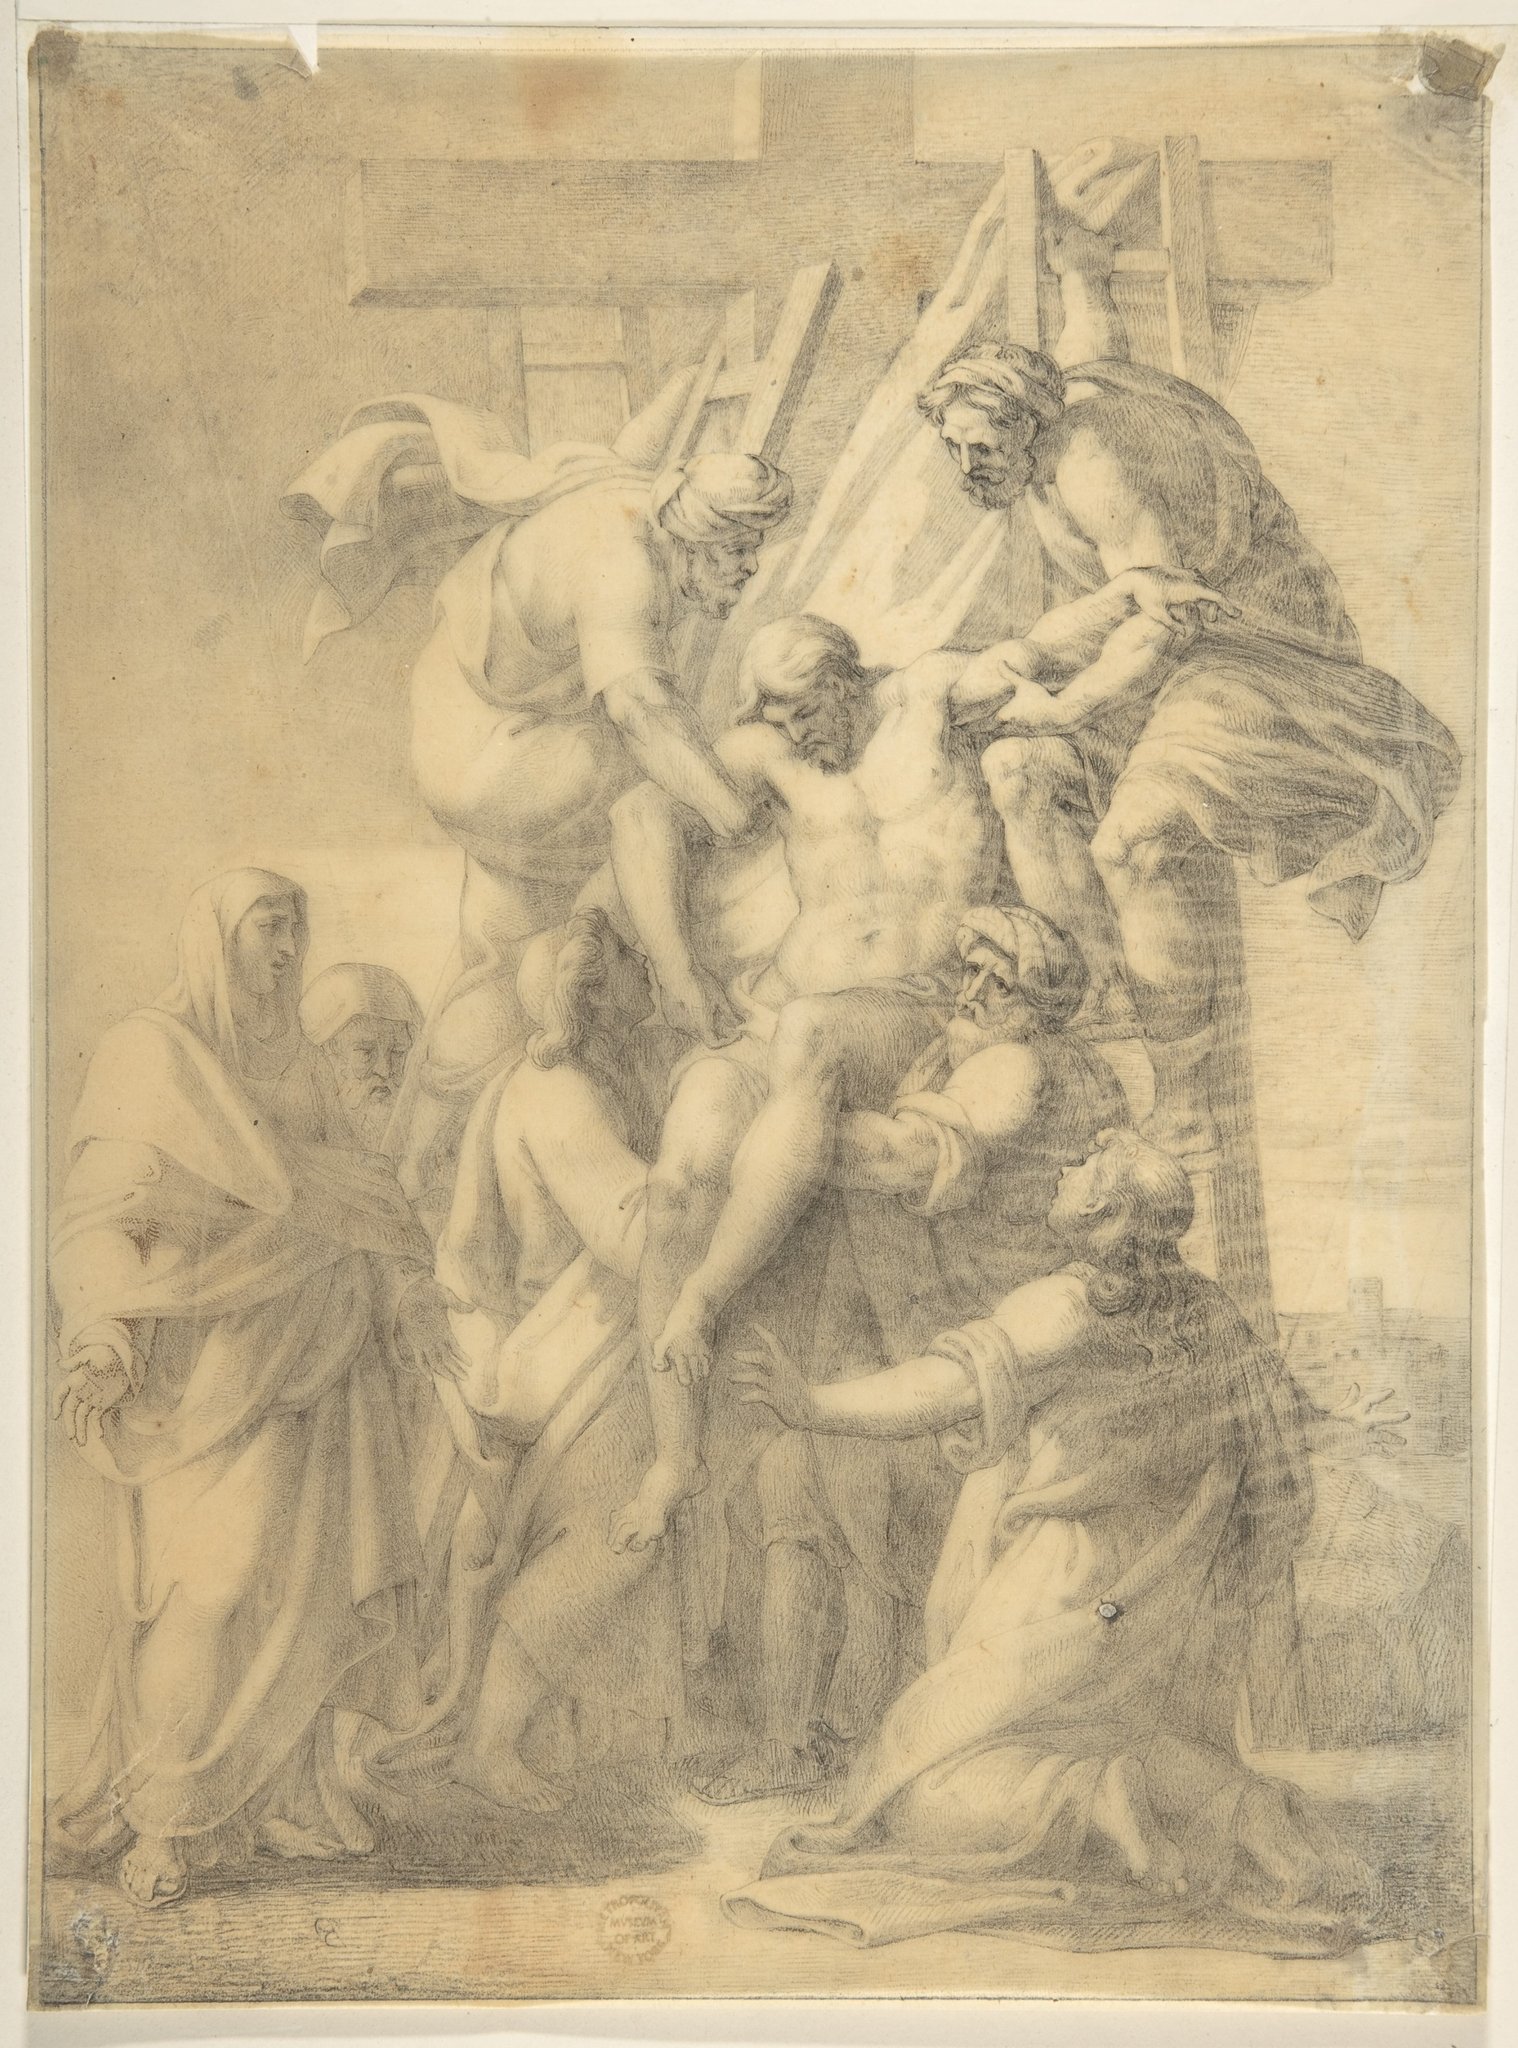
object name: drawing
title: Descent From the Cross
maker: anonymous, italian, 16th century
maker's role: artist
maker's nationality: italian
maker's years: 1550-1600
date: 1501-1600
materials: chalk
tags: christ,descent from the cross